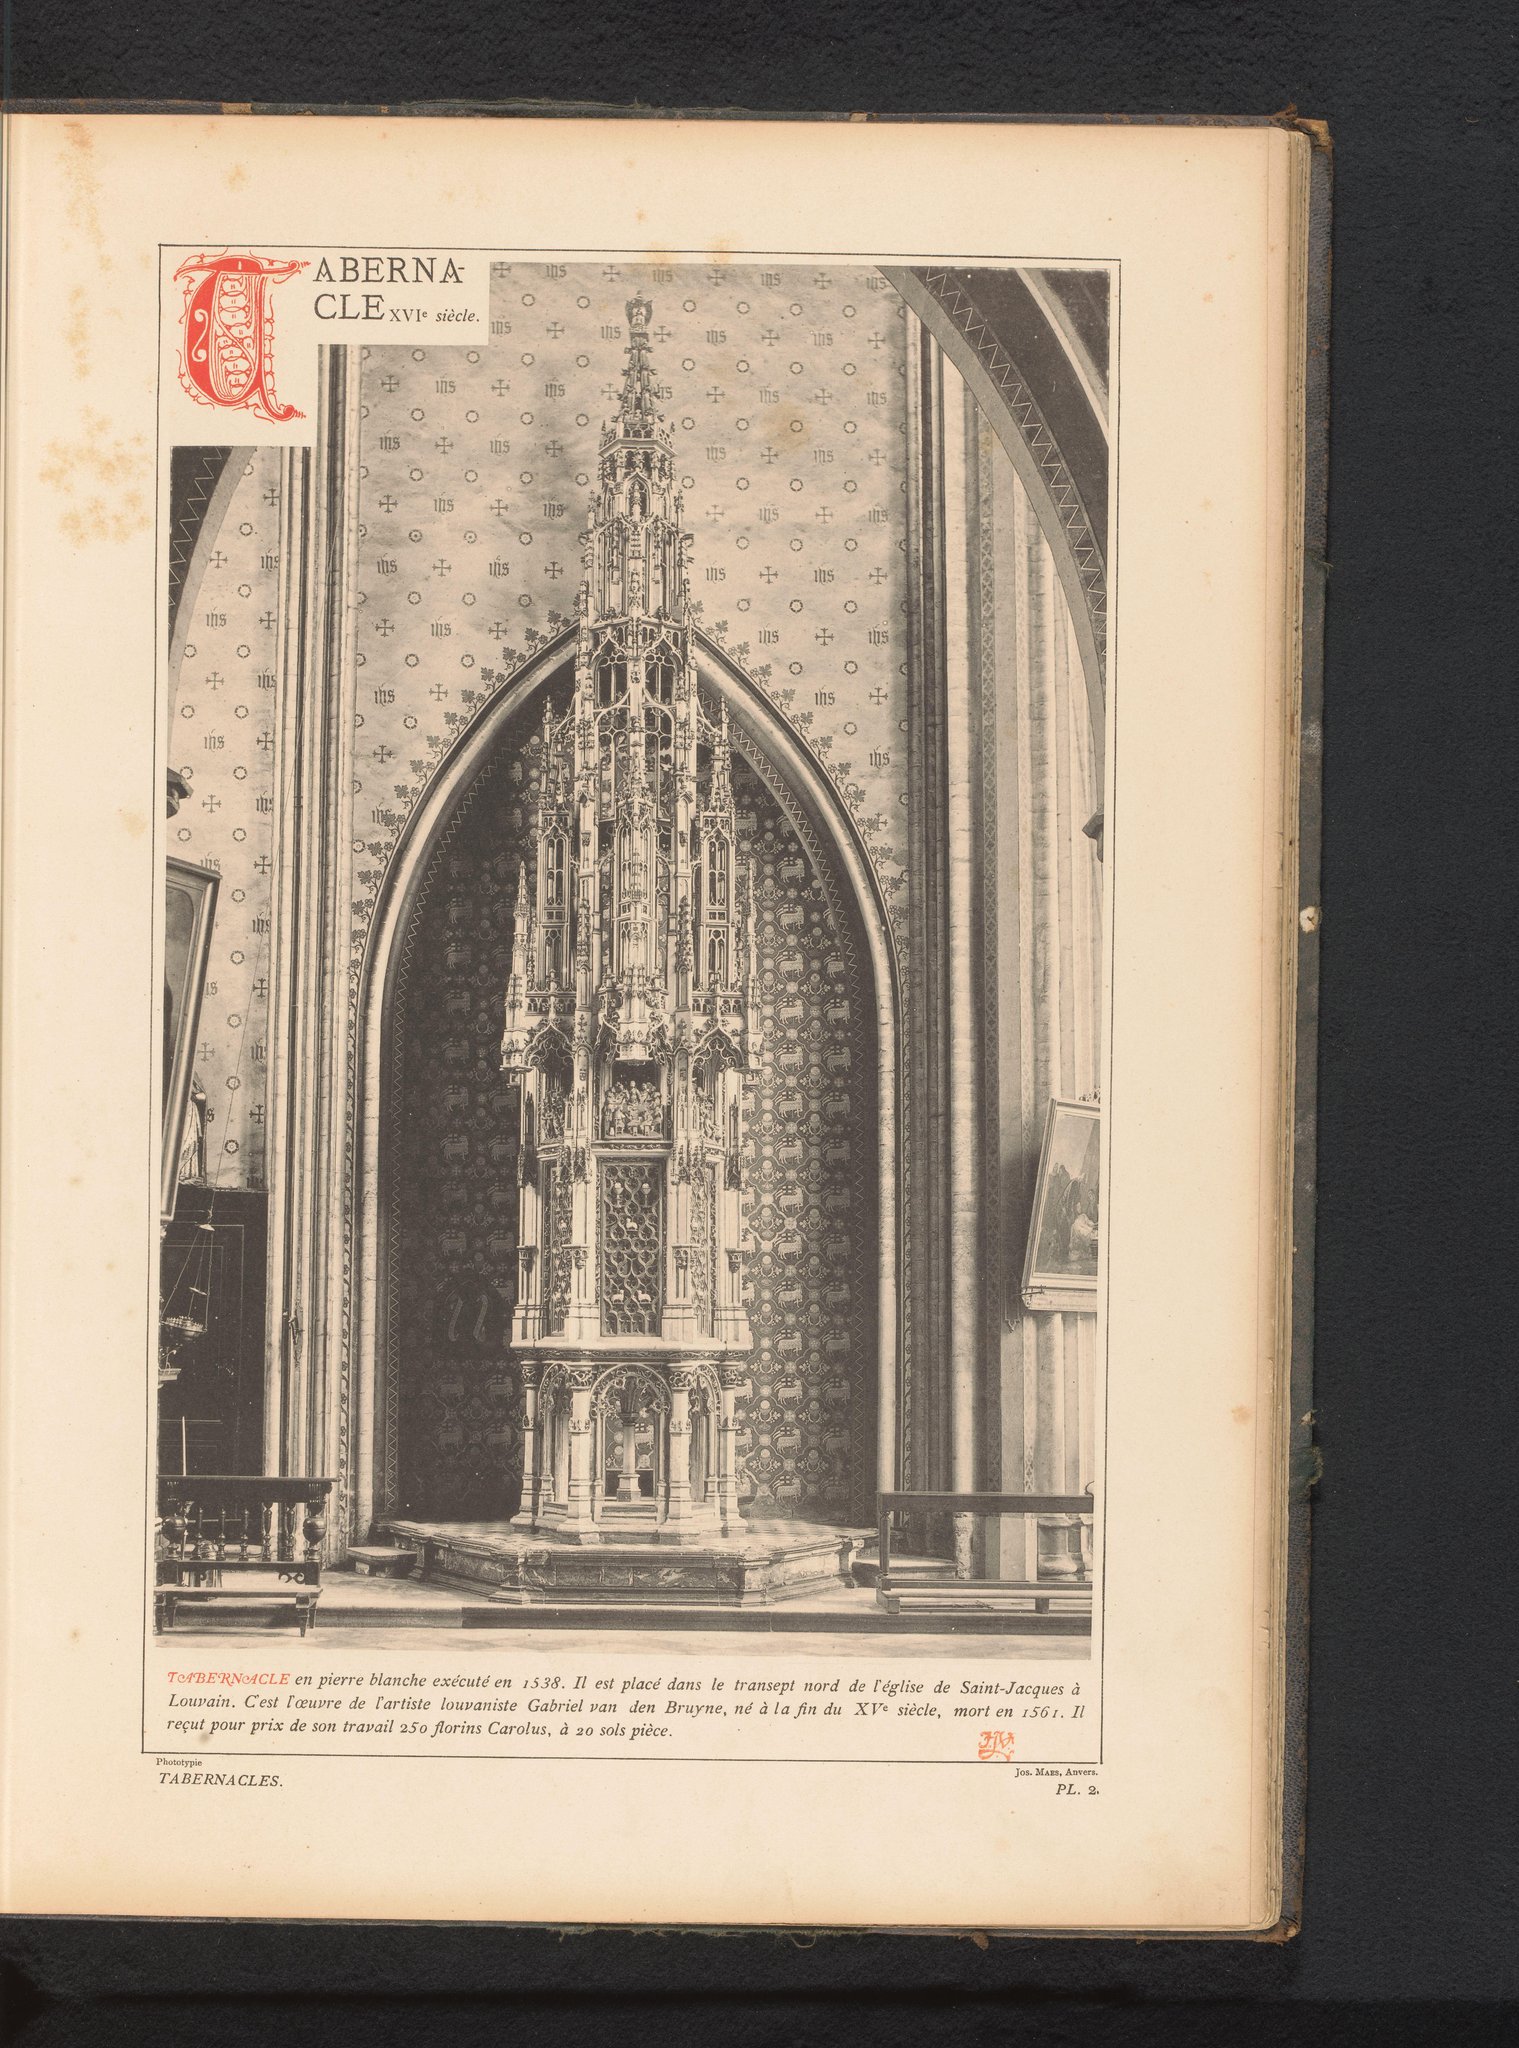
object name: page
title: Tabernacle, XVIe siècle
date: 1882-1887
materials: paper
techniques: photograph, photolithography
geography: leuven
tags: tabernacle ~ altar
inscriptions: monogram: ‘JJvY’, inscription: ‘TABERNACLES. - PL. 2.’, inscription: ‘TABERNACLE en pierre (...)’